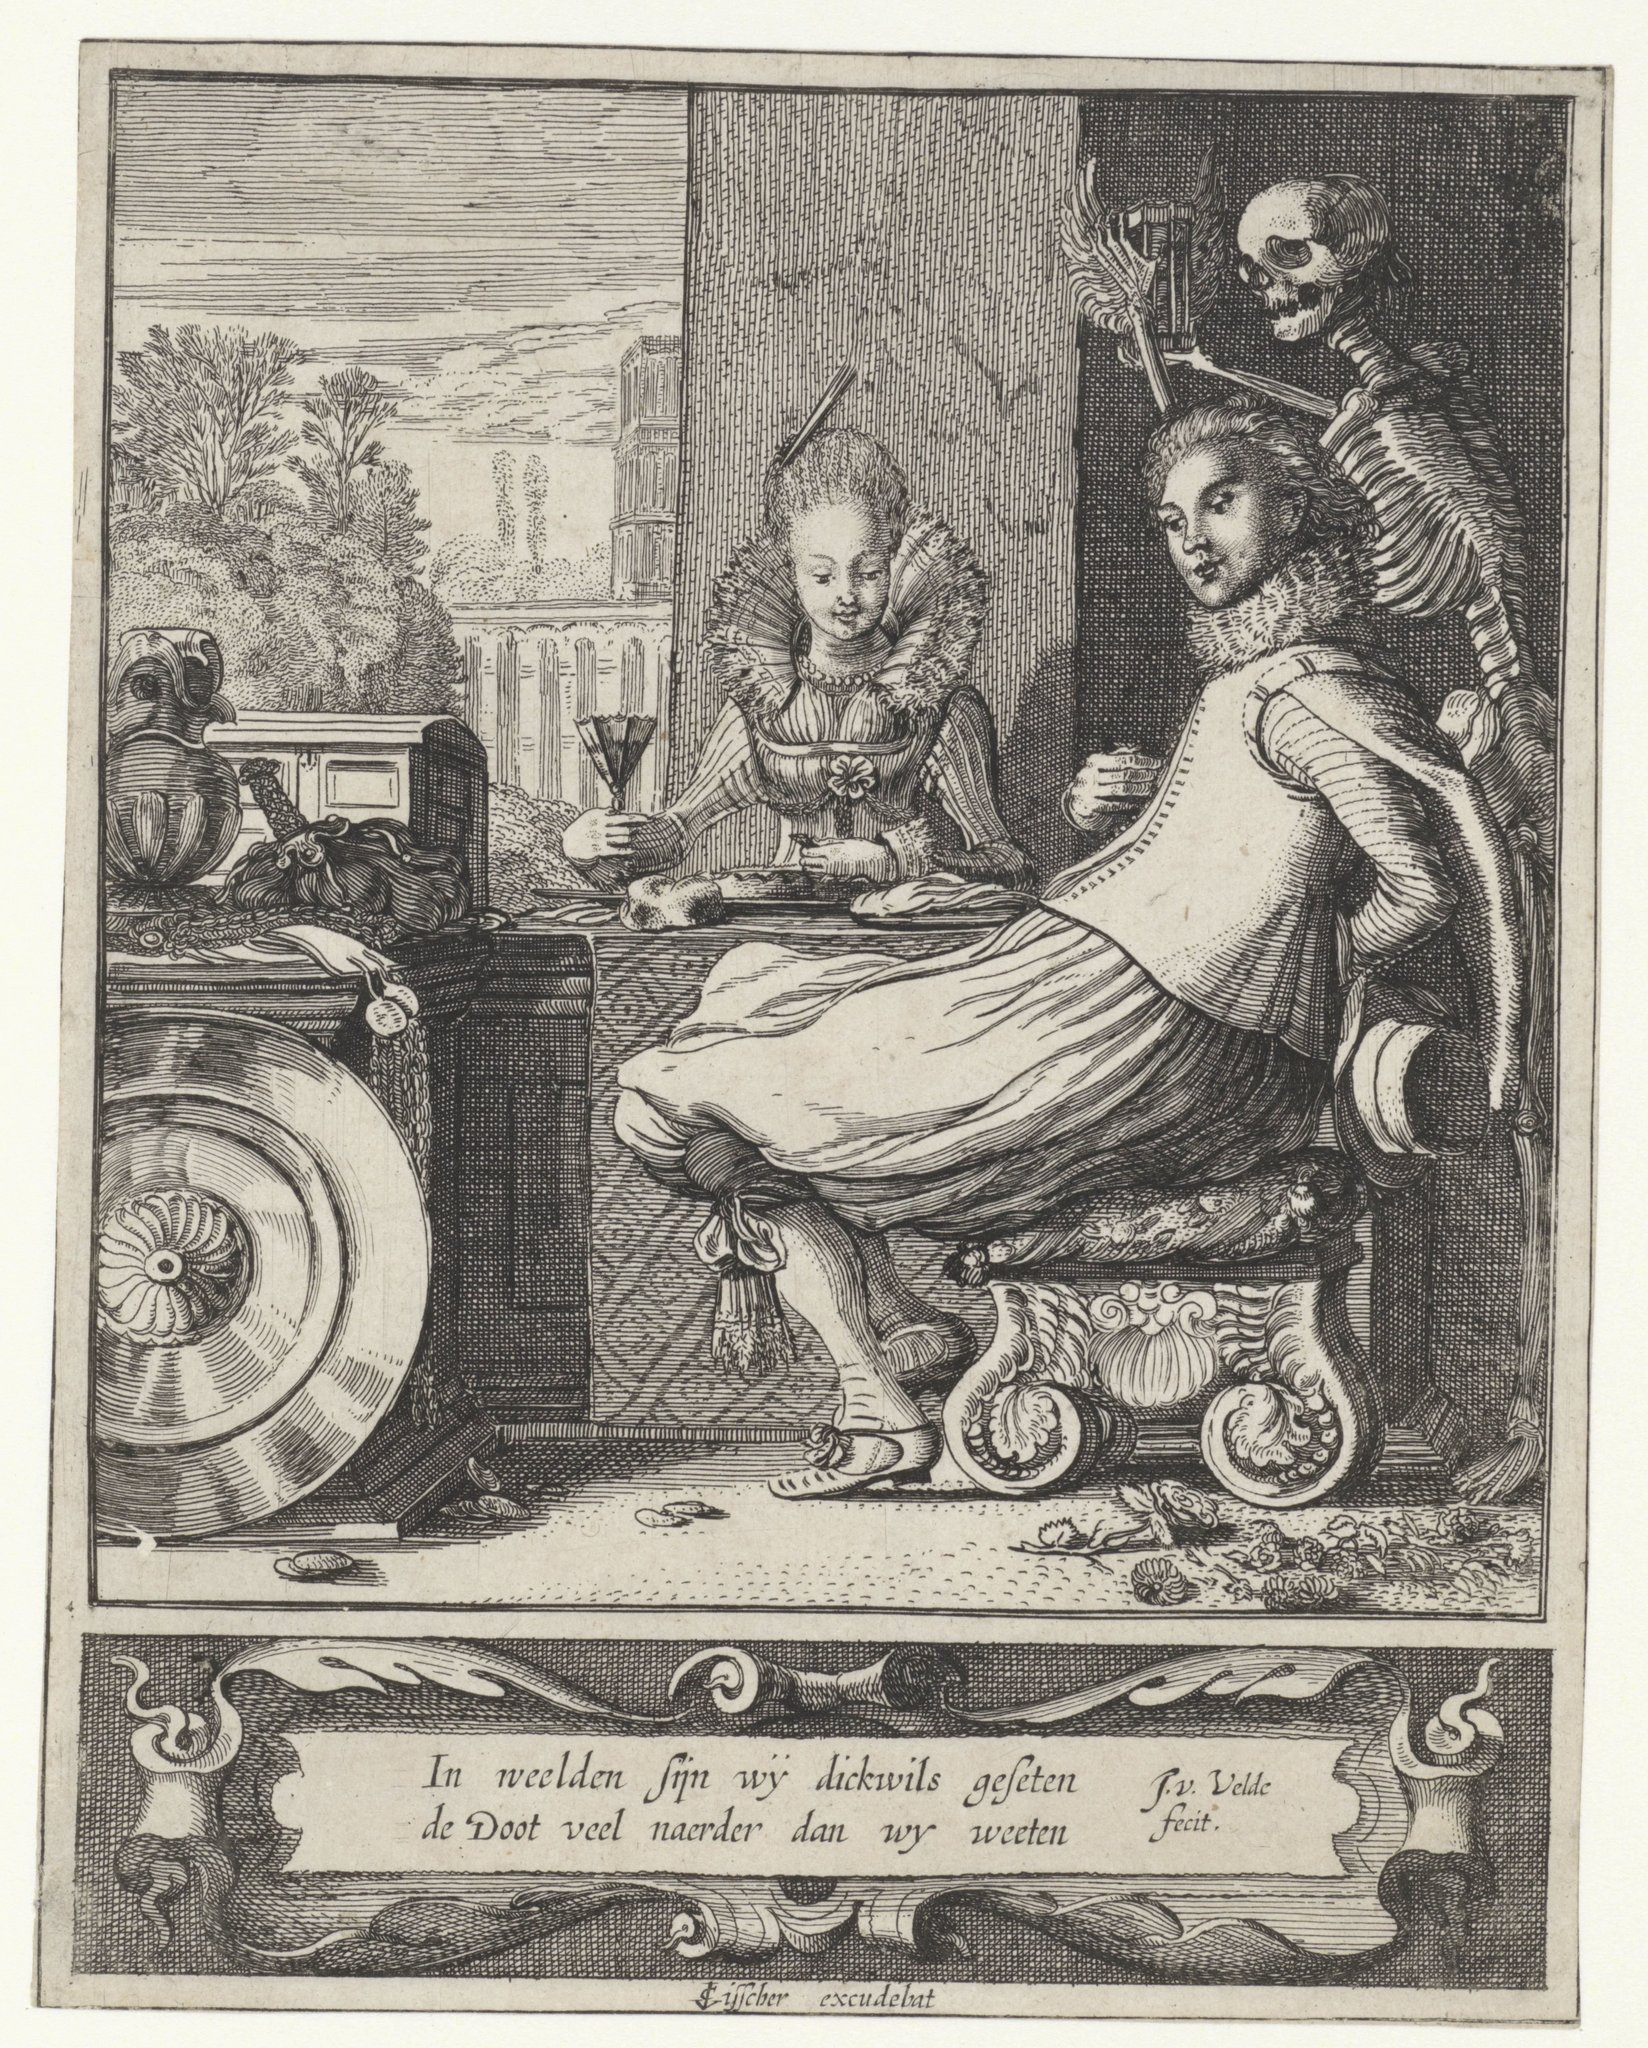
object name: print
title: Death Surprising a Young Couple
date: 1610-1650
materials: paper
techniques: etching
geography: amsterdam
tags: neck-gear ~ clothing (with name) (+ men's clothes), pin (+ women's clothes), scenes symbolizing 'vanitas', death as skeleton, death battling with life, or with the living, neck-gear: collar (+ women's clothes), shoes, sandals (+ men's clothes), trousers, breeches, etc. (breeches) (+ men's clothes), couple of lovers, clothing for the upper part of the body (doublet) (+ men's clothes), stockings, socks (+ men's clothes), sleeves (+ men's clothes), netherlands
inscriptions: caption: ‘In weelden sijn wij dickwils geseten, de Doot veel naerder dan wy weten’, address: ‘CVisscher excudebat’, signature: ‘J. v. Velde fecit.’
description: A sumptuously attired couple enjoy food, drink, and luxury objects. Death appears behind them, holding a winged hourglass as a warning about the brevity of life. The withered flowers on the ground, too, symbolize transience. Young couples overtaken by Death was a popular theme in the 16th and 17th century, when life was shorter and death always around the corner.